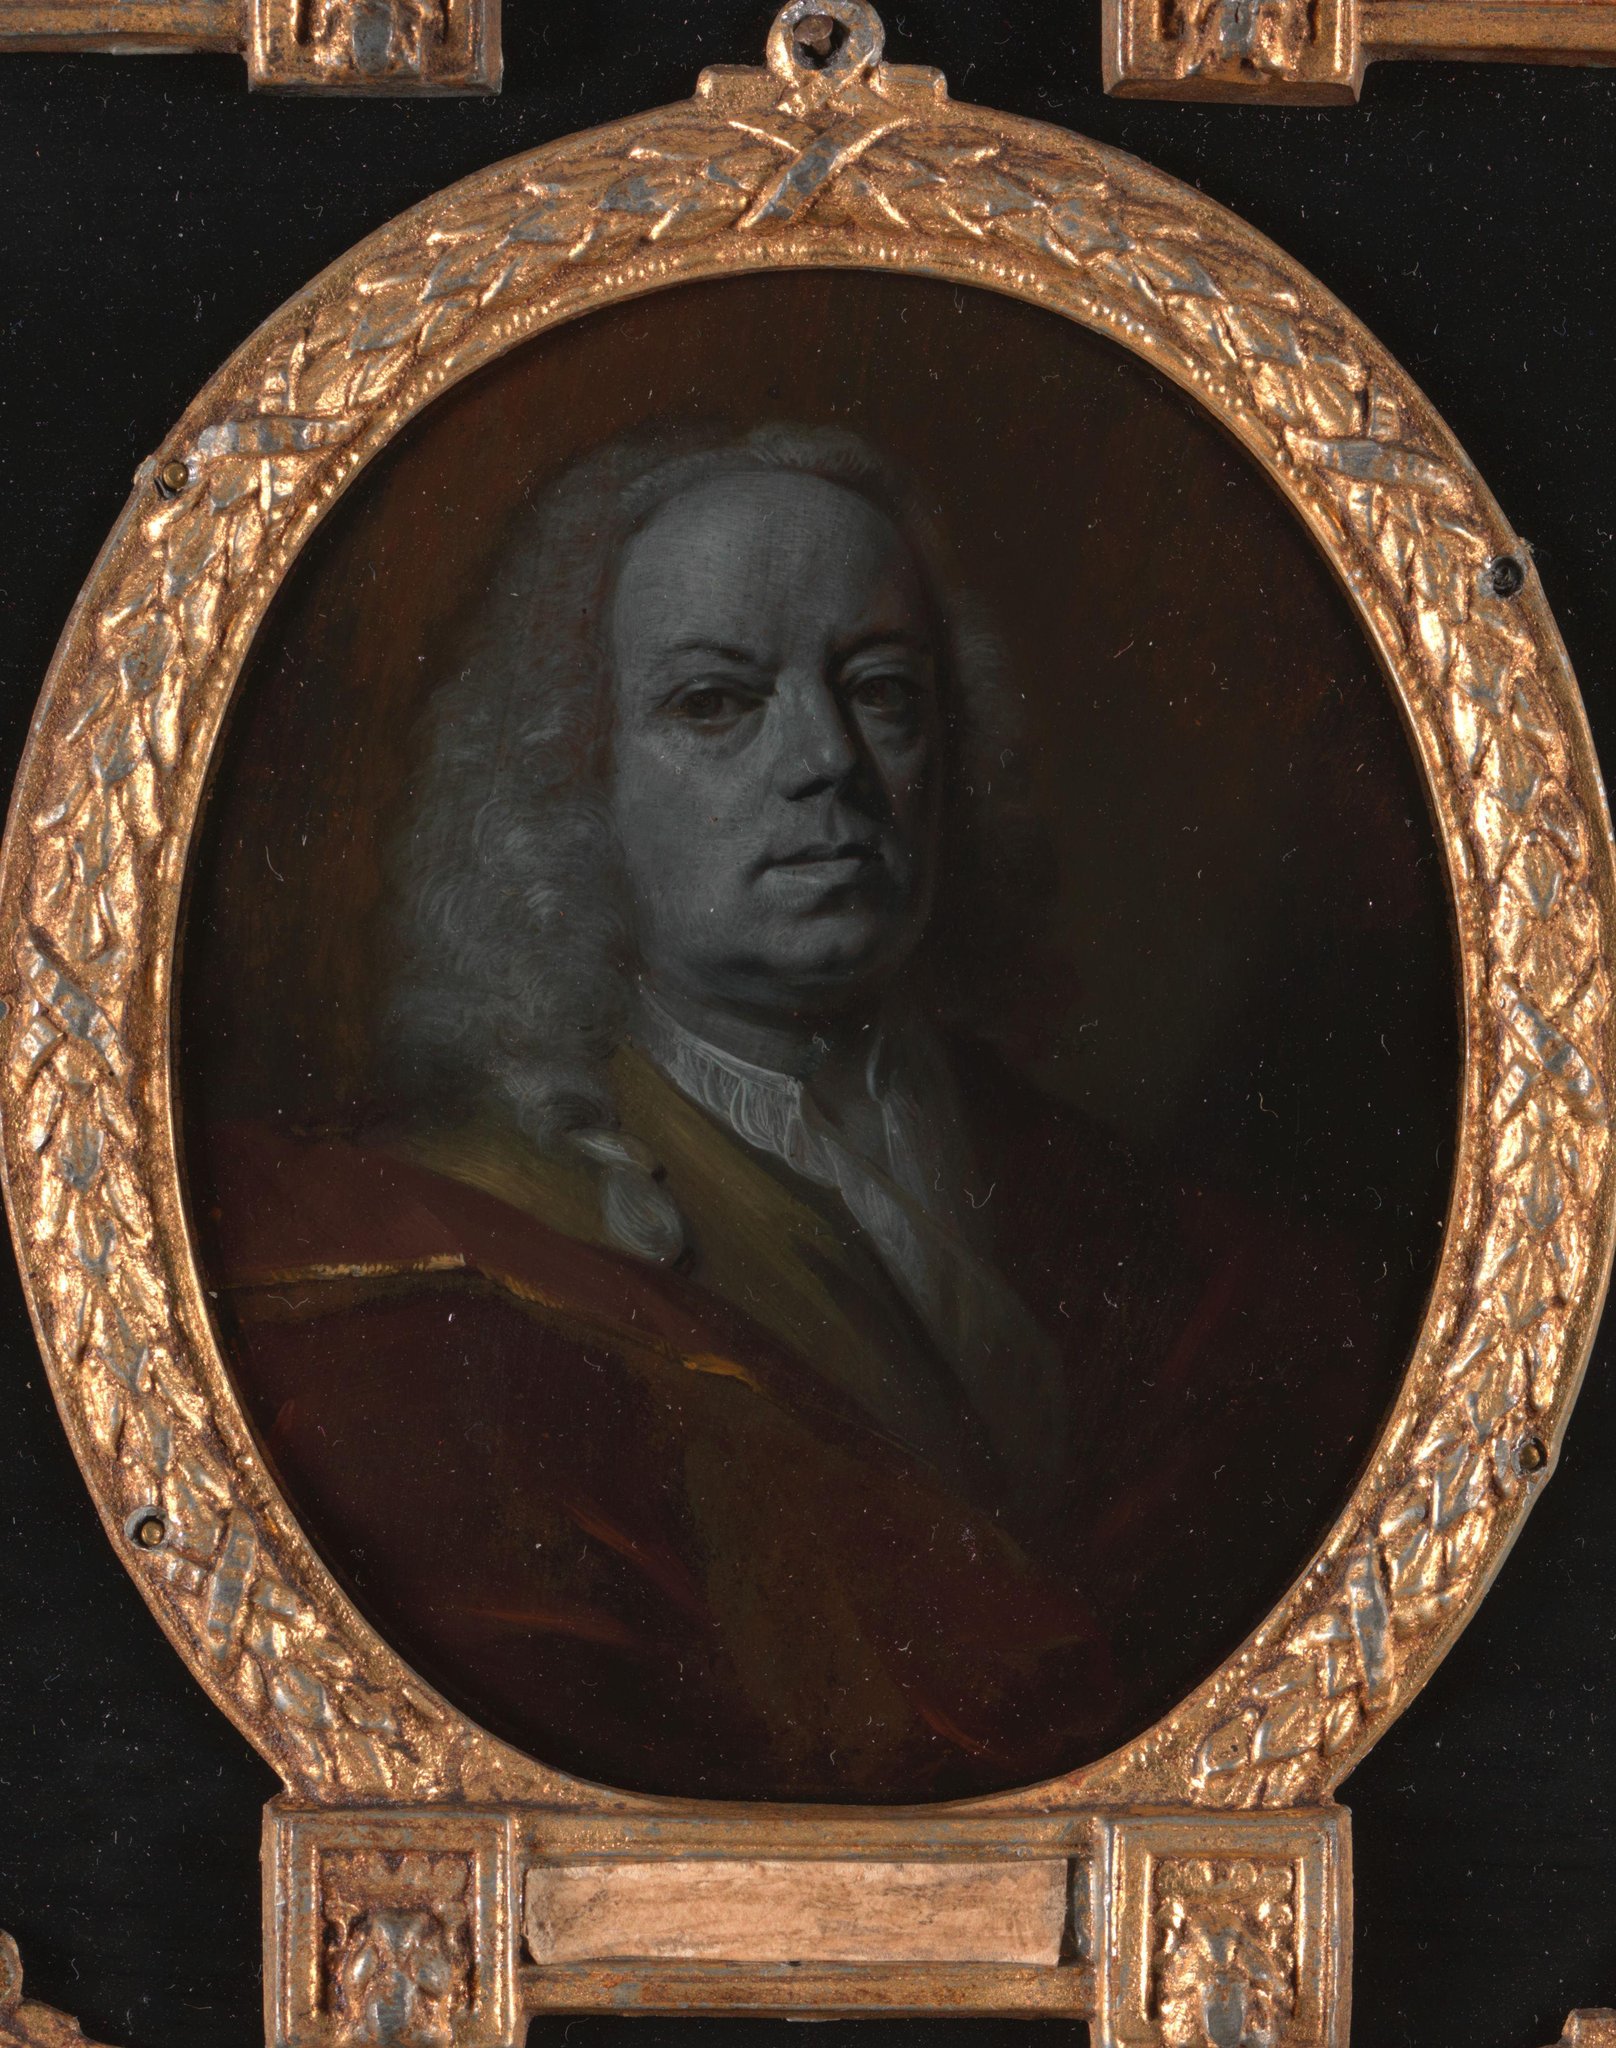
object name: grisaille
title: Portrait of Frans Greenwood, Miniaturist, Glass Engraver and Poet in Dordrecht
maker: aert schouman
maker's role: draughtsman, painter, print maker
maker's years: 1710-1792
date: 1732-1771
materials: copper, oil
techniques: grisaille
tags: dordrecht, frans greenwood, historical persons, portrait of a writer, portrait, self-portrait of artist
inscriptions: signature: ‘AS’, inscription: ‘Frans Greenwood Gebooren den 17 April 1680 / 1740 30/4’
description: Portret van Frans Greenwood. Miniaturist, glasgraveur en dichter te Dordrecht. Buste in ovaal naar rechts. Onderdeel van een verzameling portretten van Nederlandse dichters.